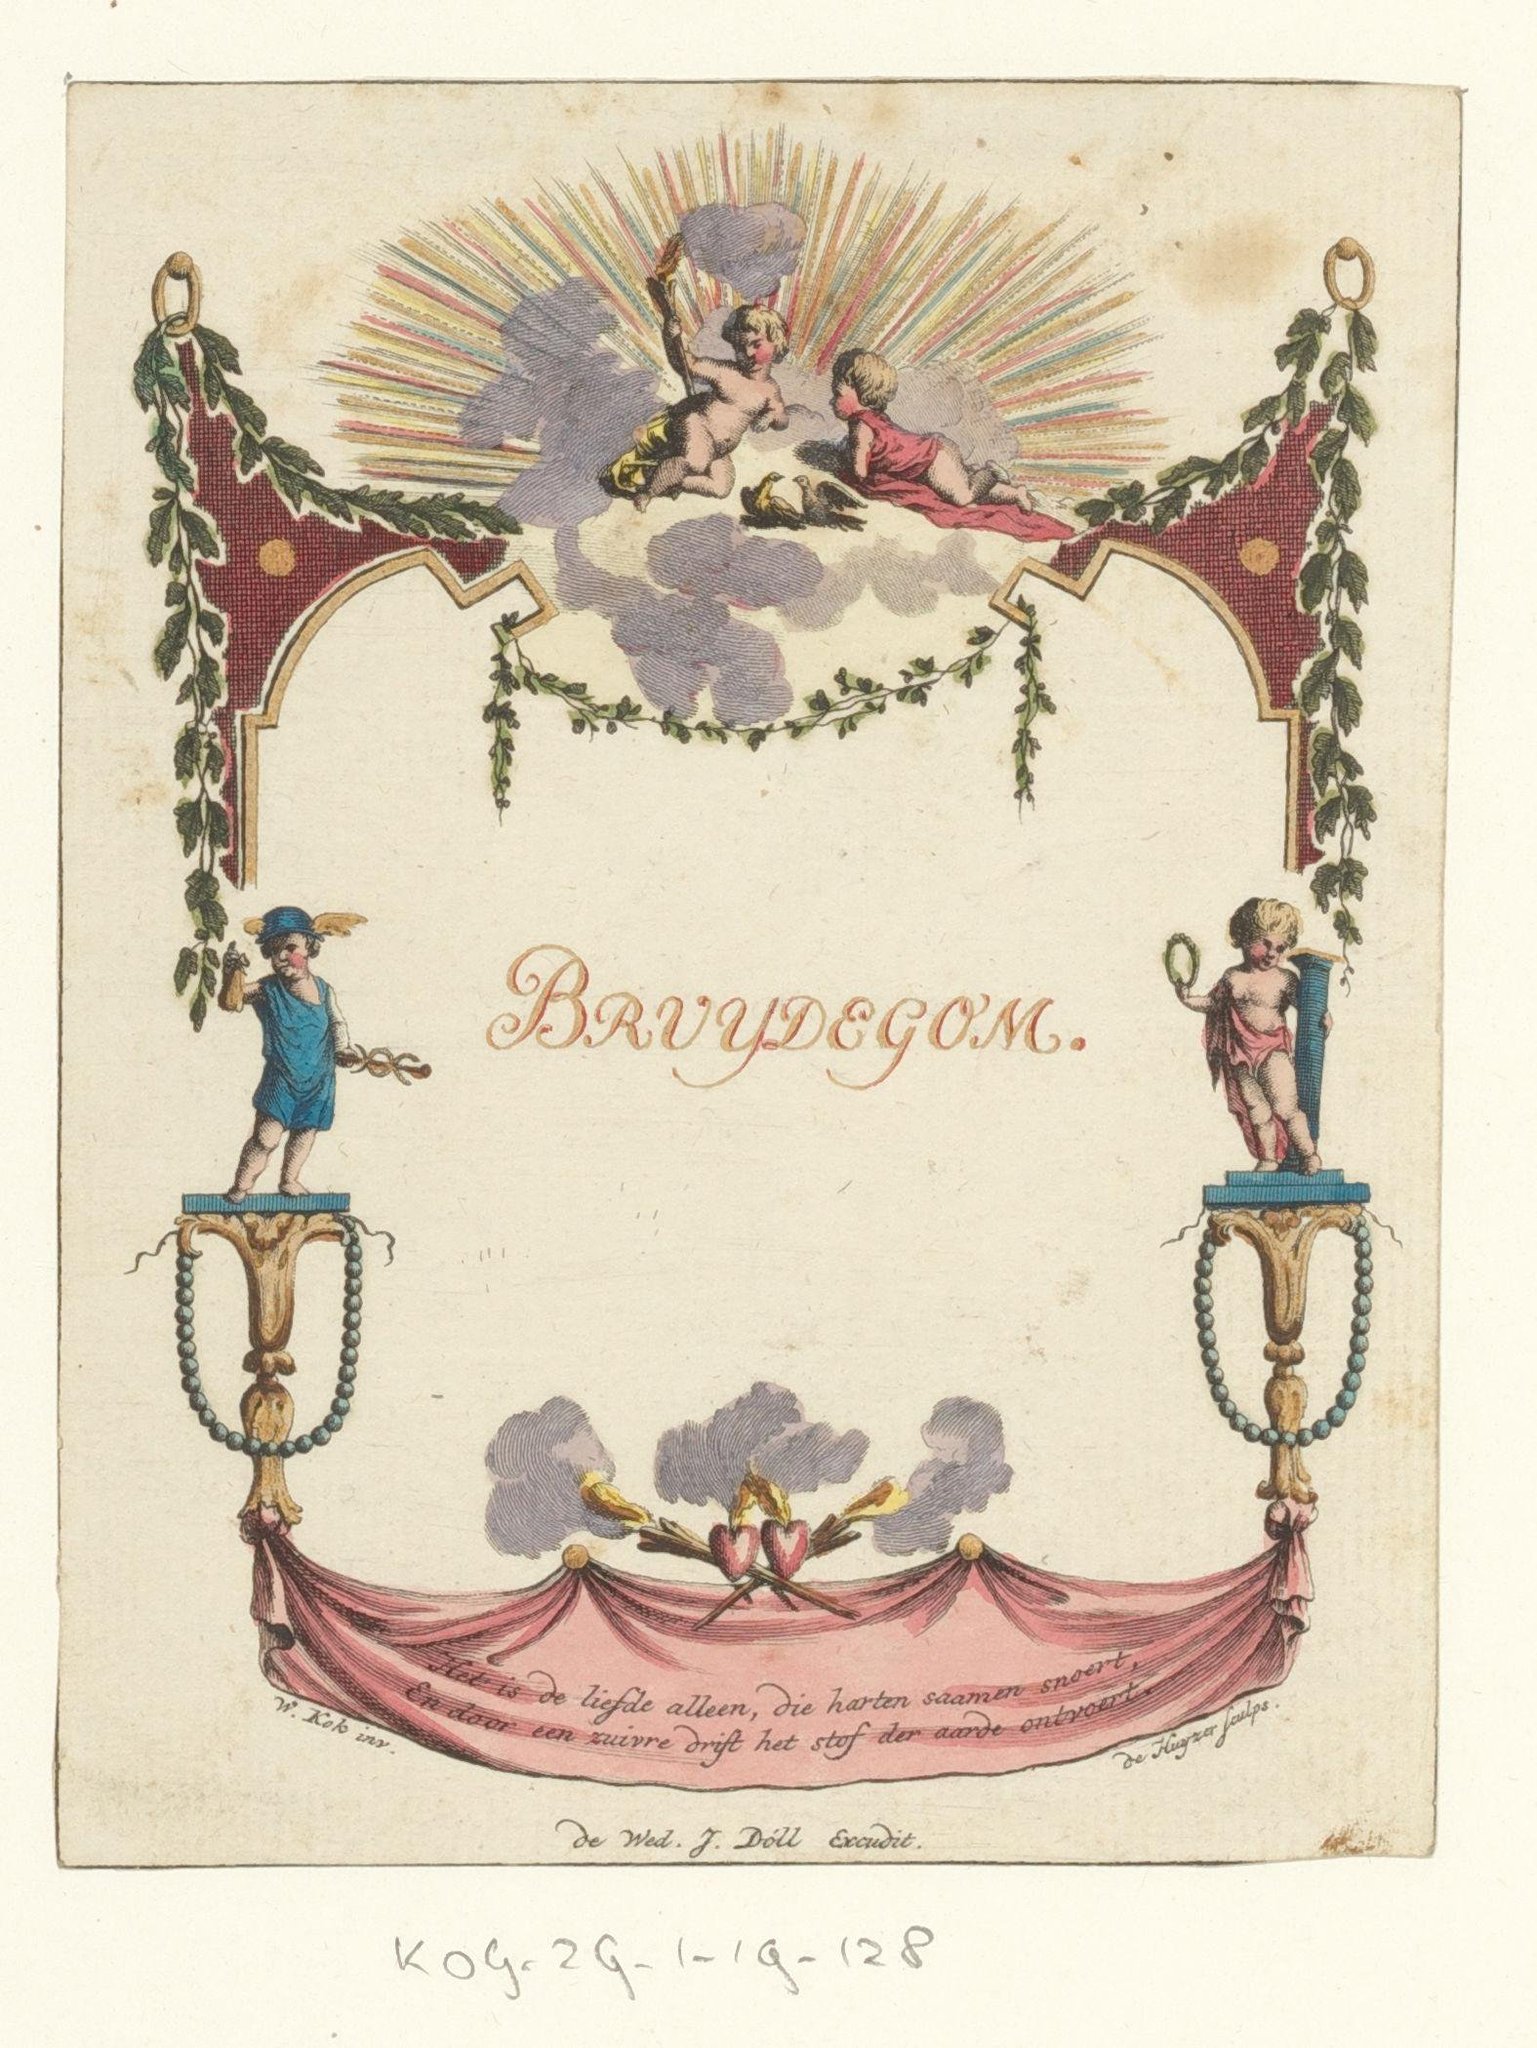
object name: print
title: Naamkaartje voor de bruidegom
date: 1782-1804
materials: paint, paper, watercolor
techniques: brush, calligraphy, etching, hand coloring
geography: netherlands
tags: wedding feast, wedding meal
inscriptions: collector's mark: Lugt 1641, collector's mark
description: Naamkaartje voor de bruidegom, te gebruiken bij de tafelindeling bij een bruiloftsmaal. Decoratieve omlijsting met putti, huwelijkssymboliek en tweeregelig motto over de liefde. Onderwerpsrubrieken binnen de Atlas Zeden en Gewoonten: Des Menschen Begin, Midden en Einde. Bruiloft en huwelijk.